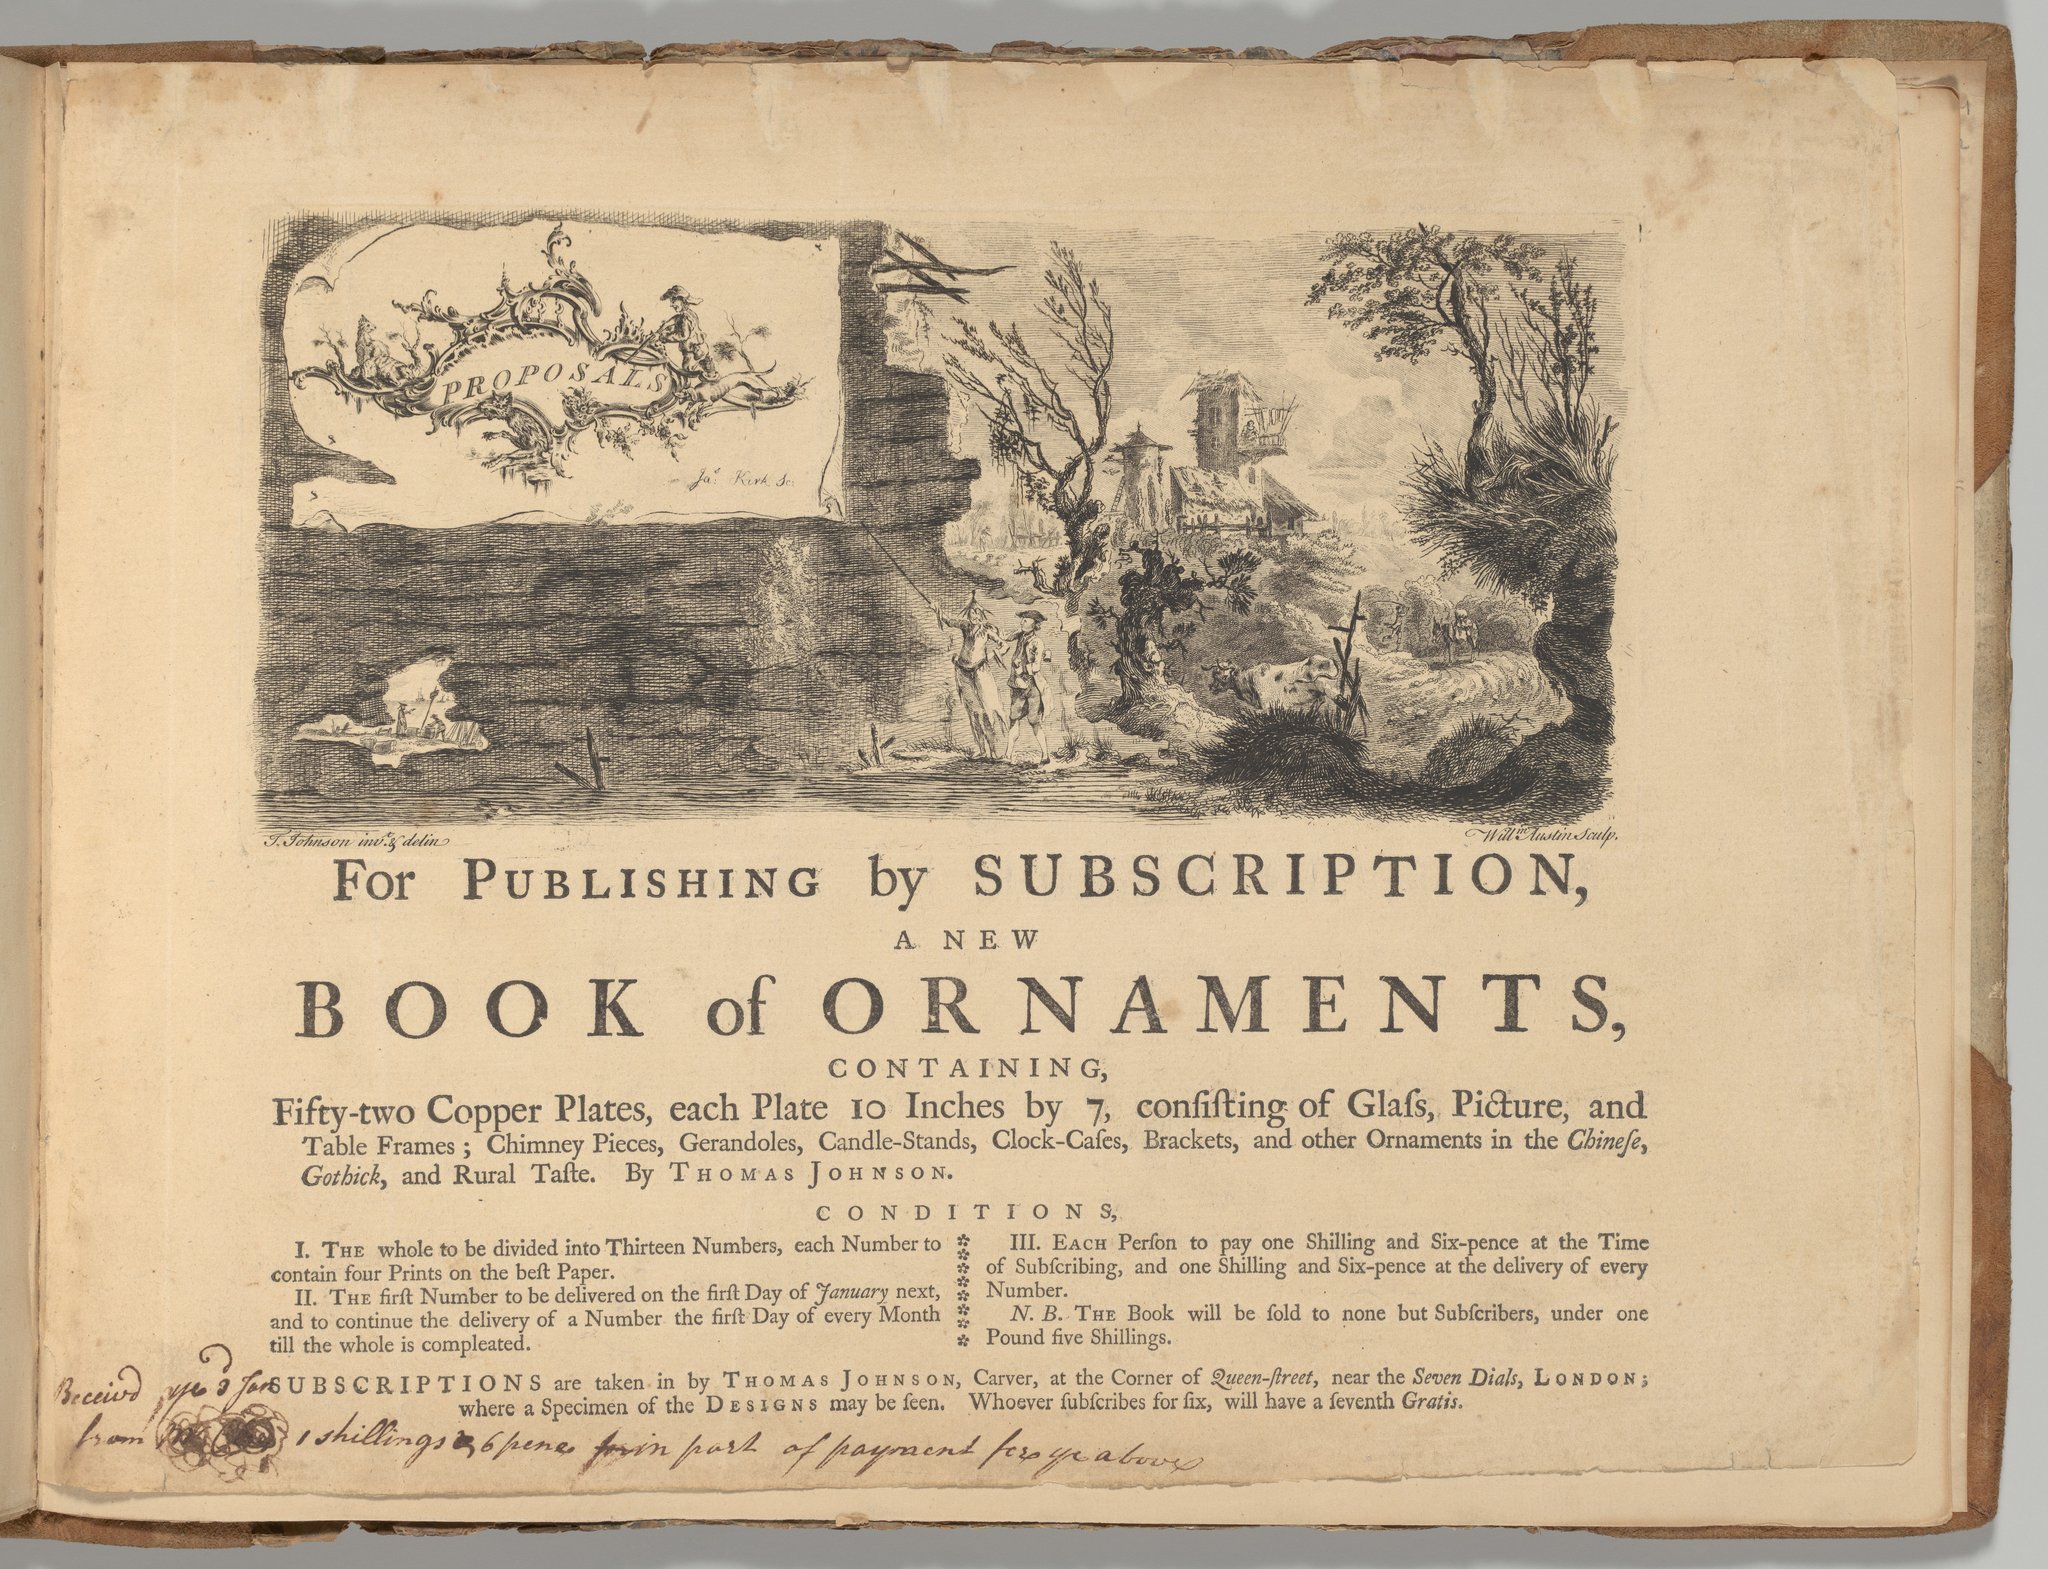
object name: book print ornament architecture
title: A New Book of Ornaments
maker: thomas johnson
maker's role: author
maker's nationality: british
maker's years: 1714-1778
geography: london